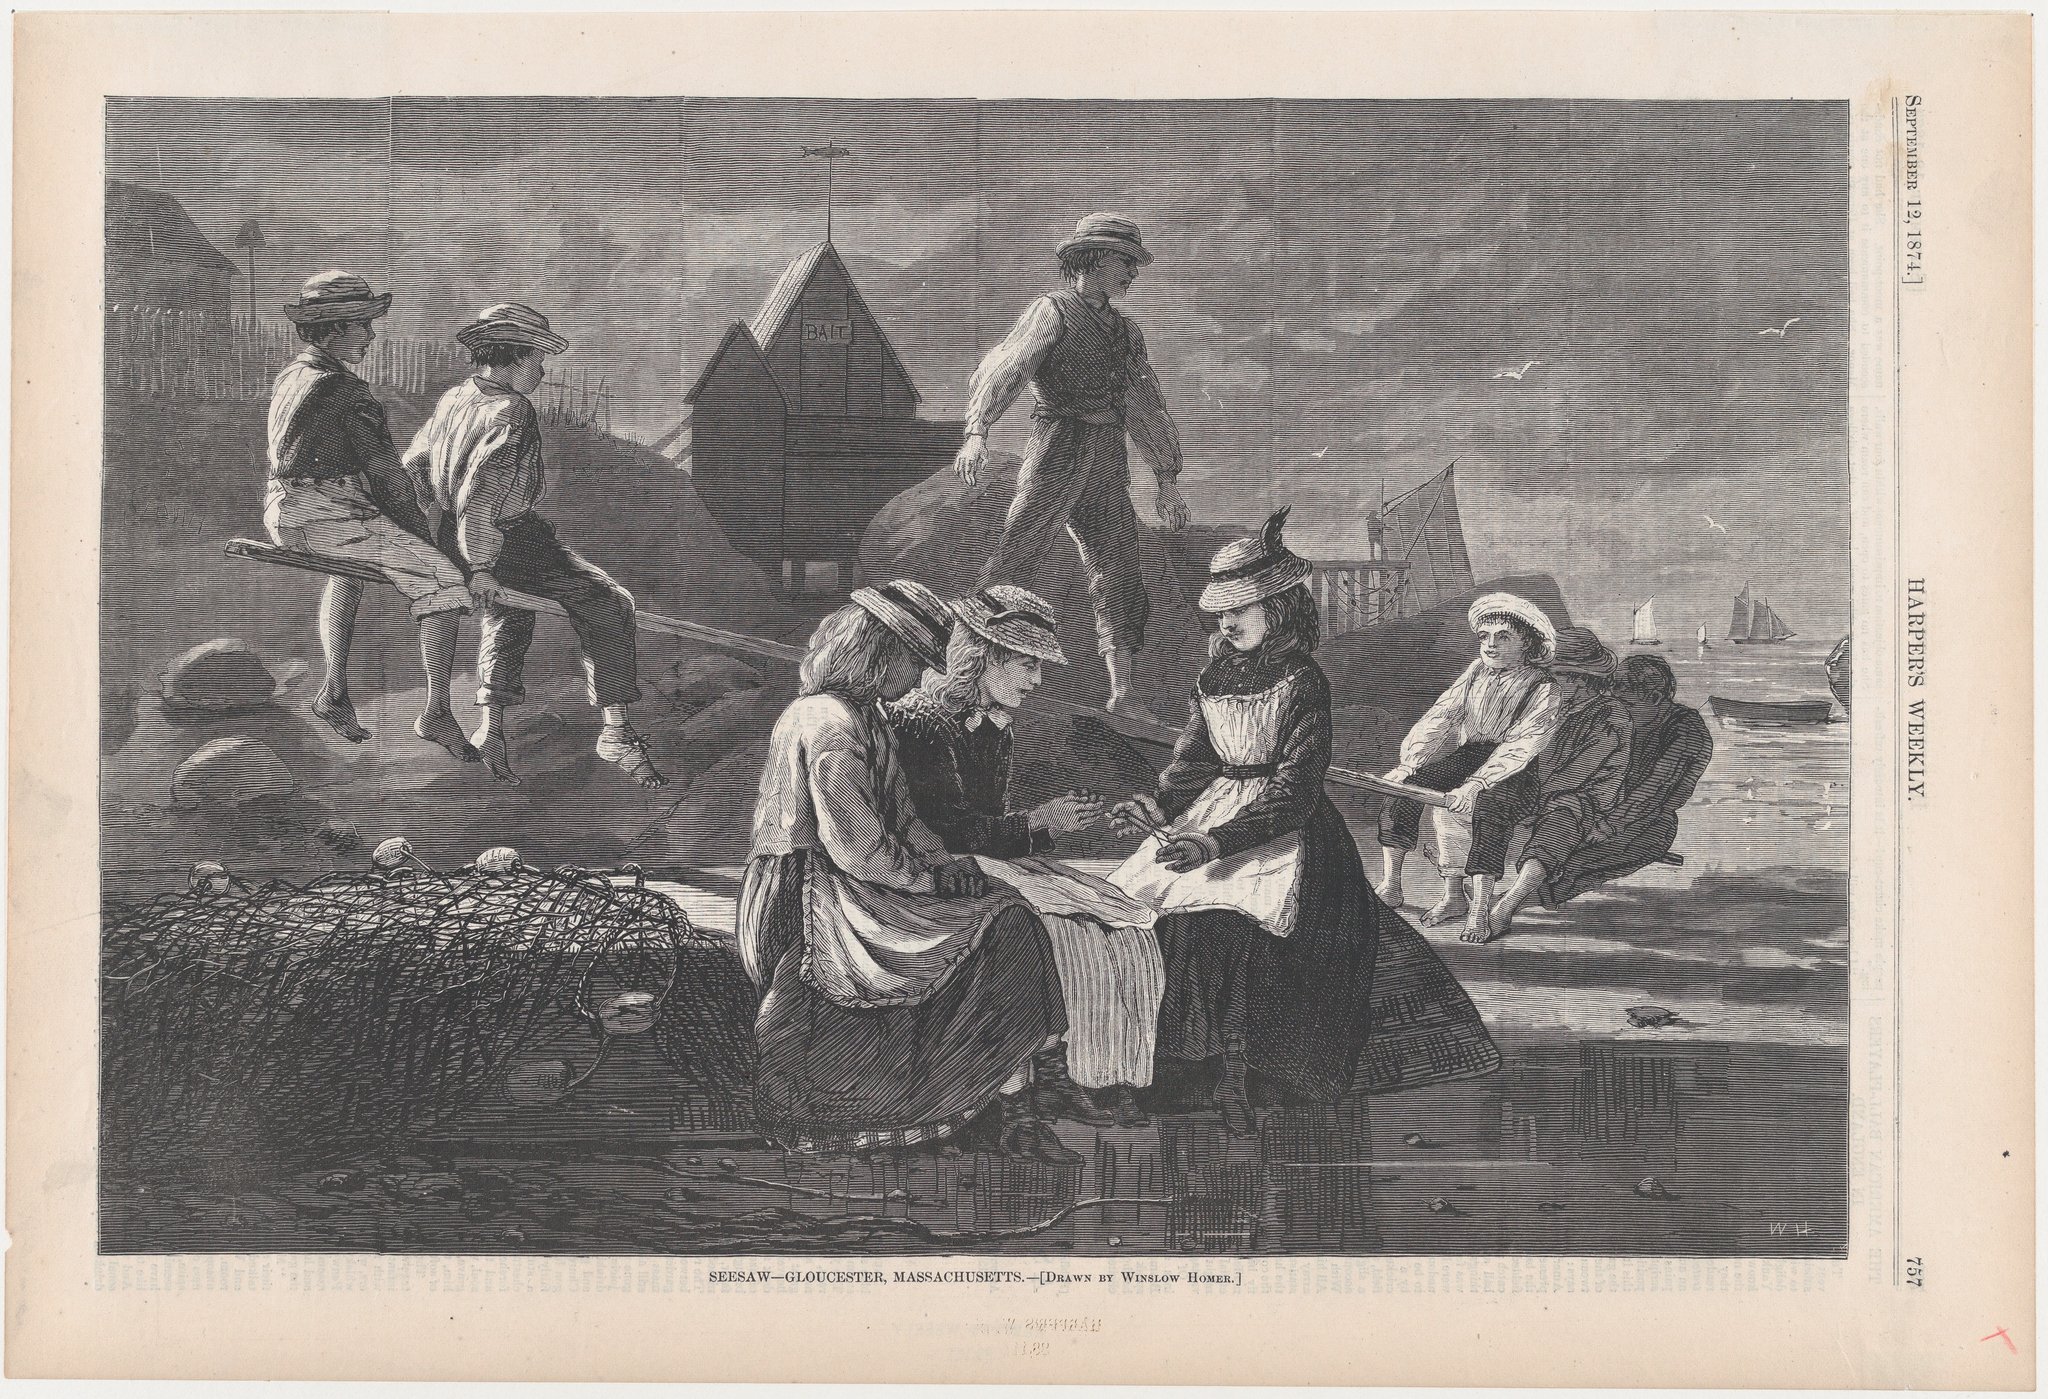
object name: print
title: Seesaw, Gloucester, Massachusetts (from "Harper's Weekly," Vol. XVIII)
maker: winslow homer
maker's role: artist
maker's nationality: american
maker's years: 1836-1910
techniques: engraving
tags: houses,boys,women,playing